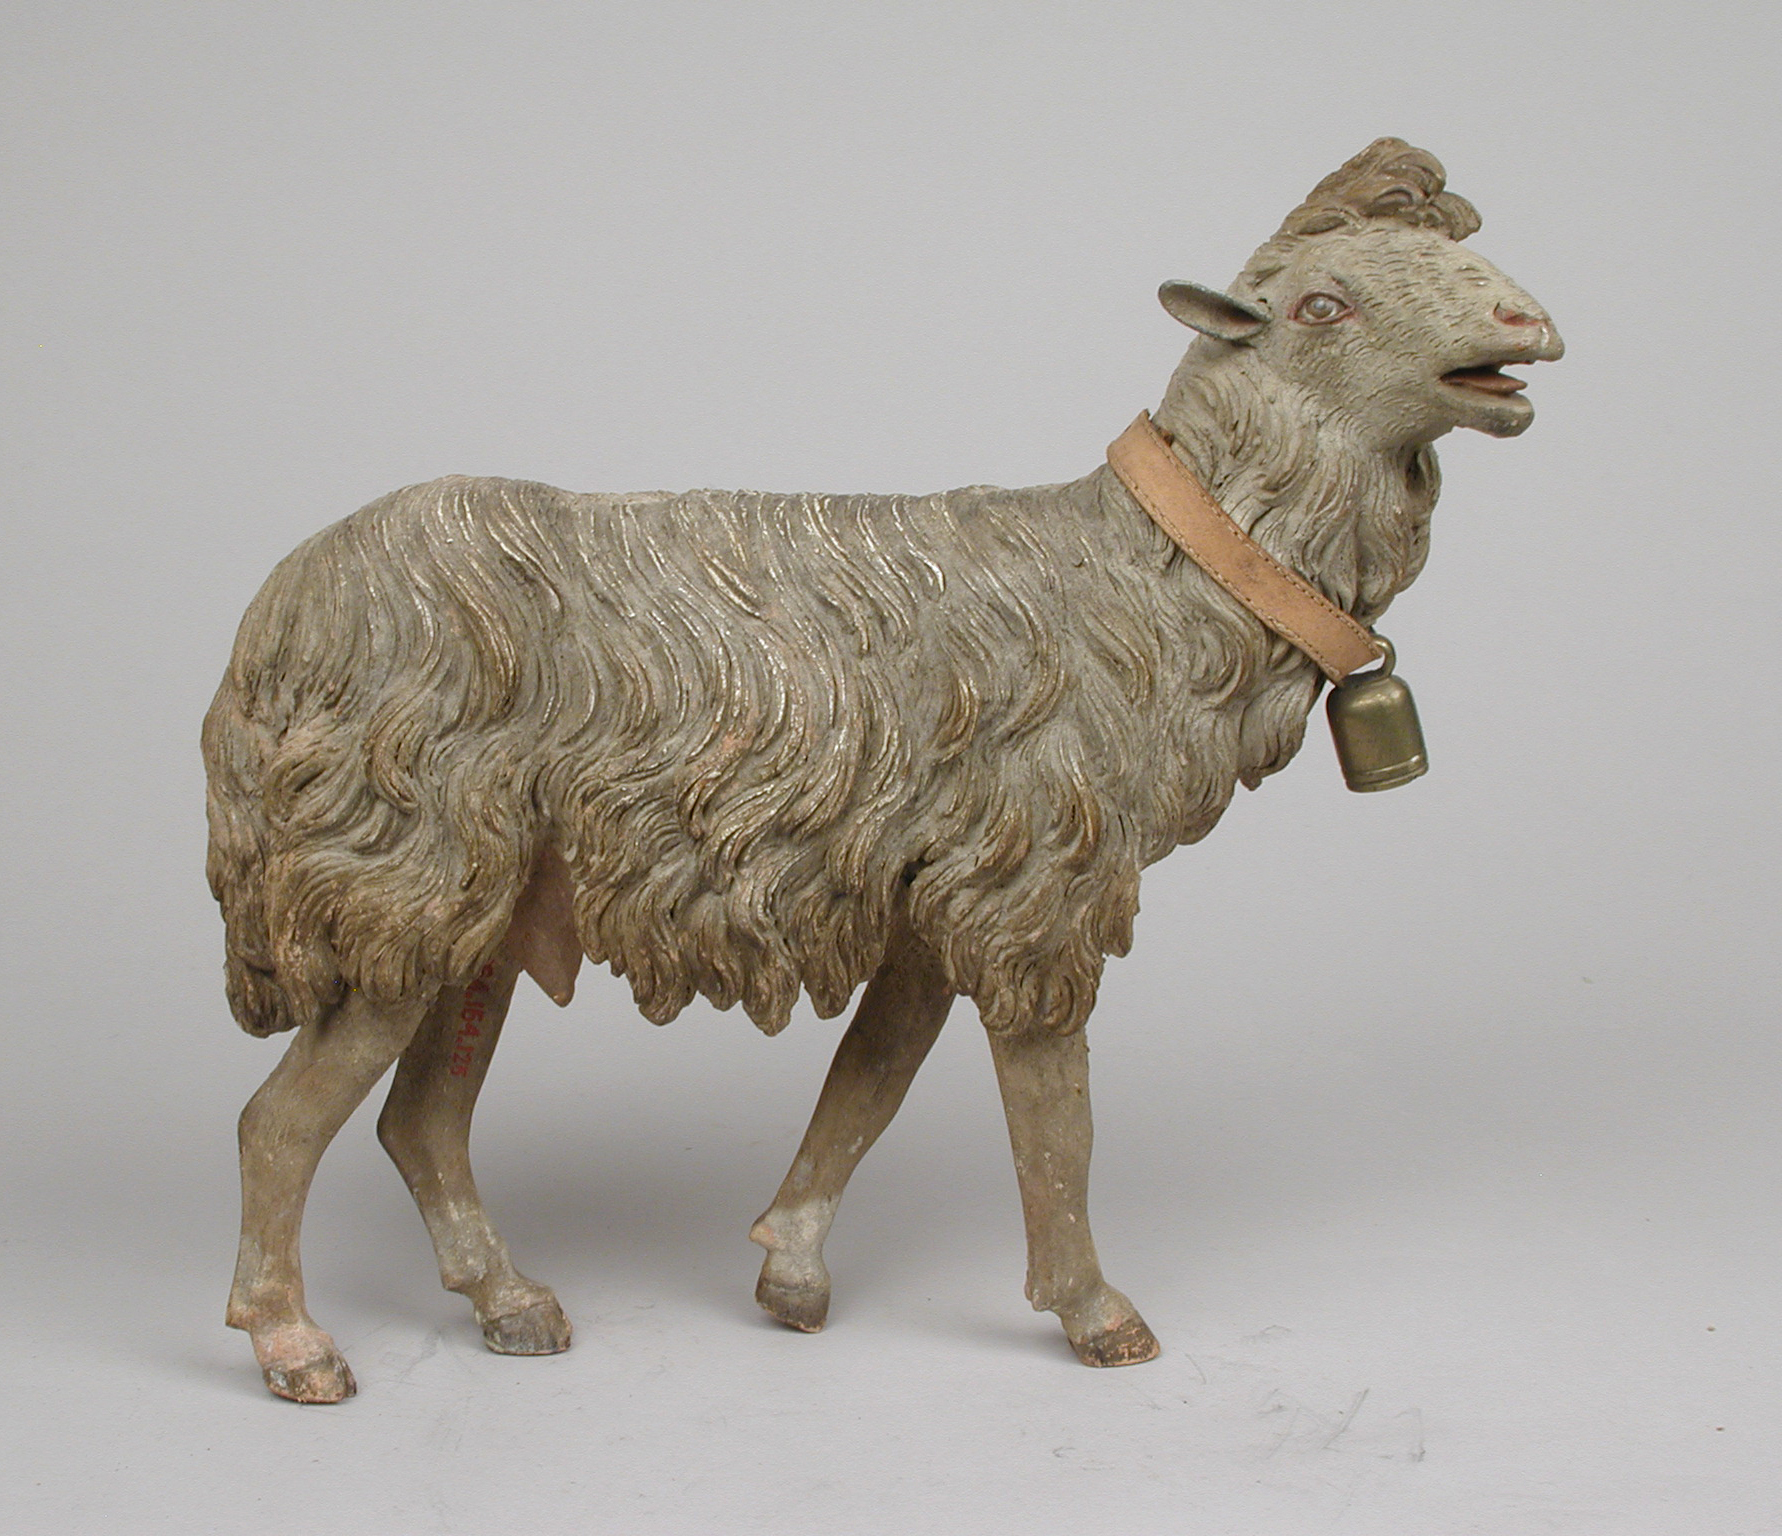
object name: crèche figure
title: Standing sheep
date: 1751-1800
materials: metal, terracotta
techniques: polychrome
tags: sheep